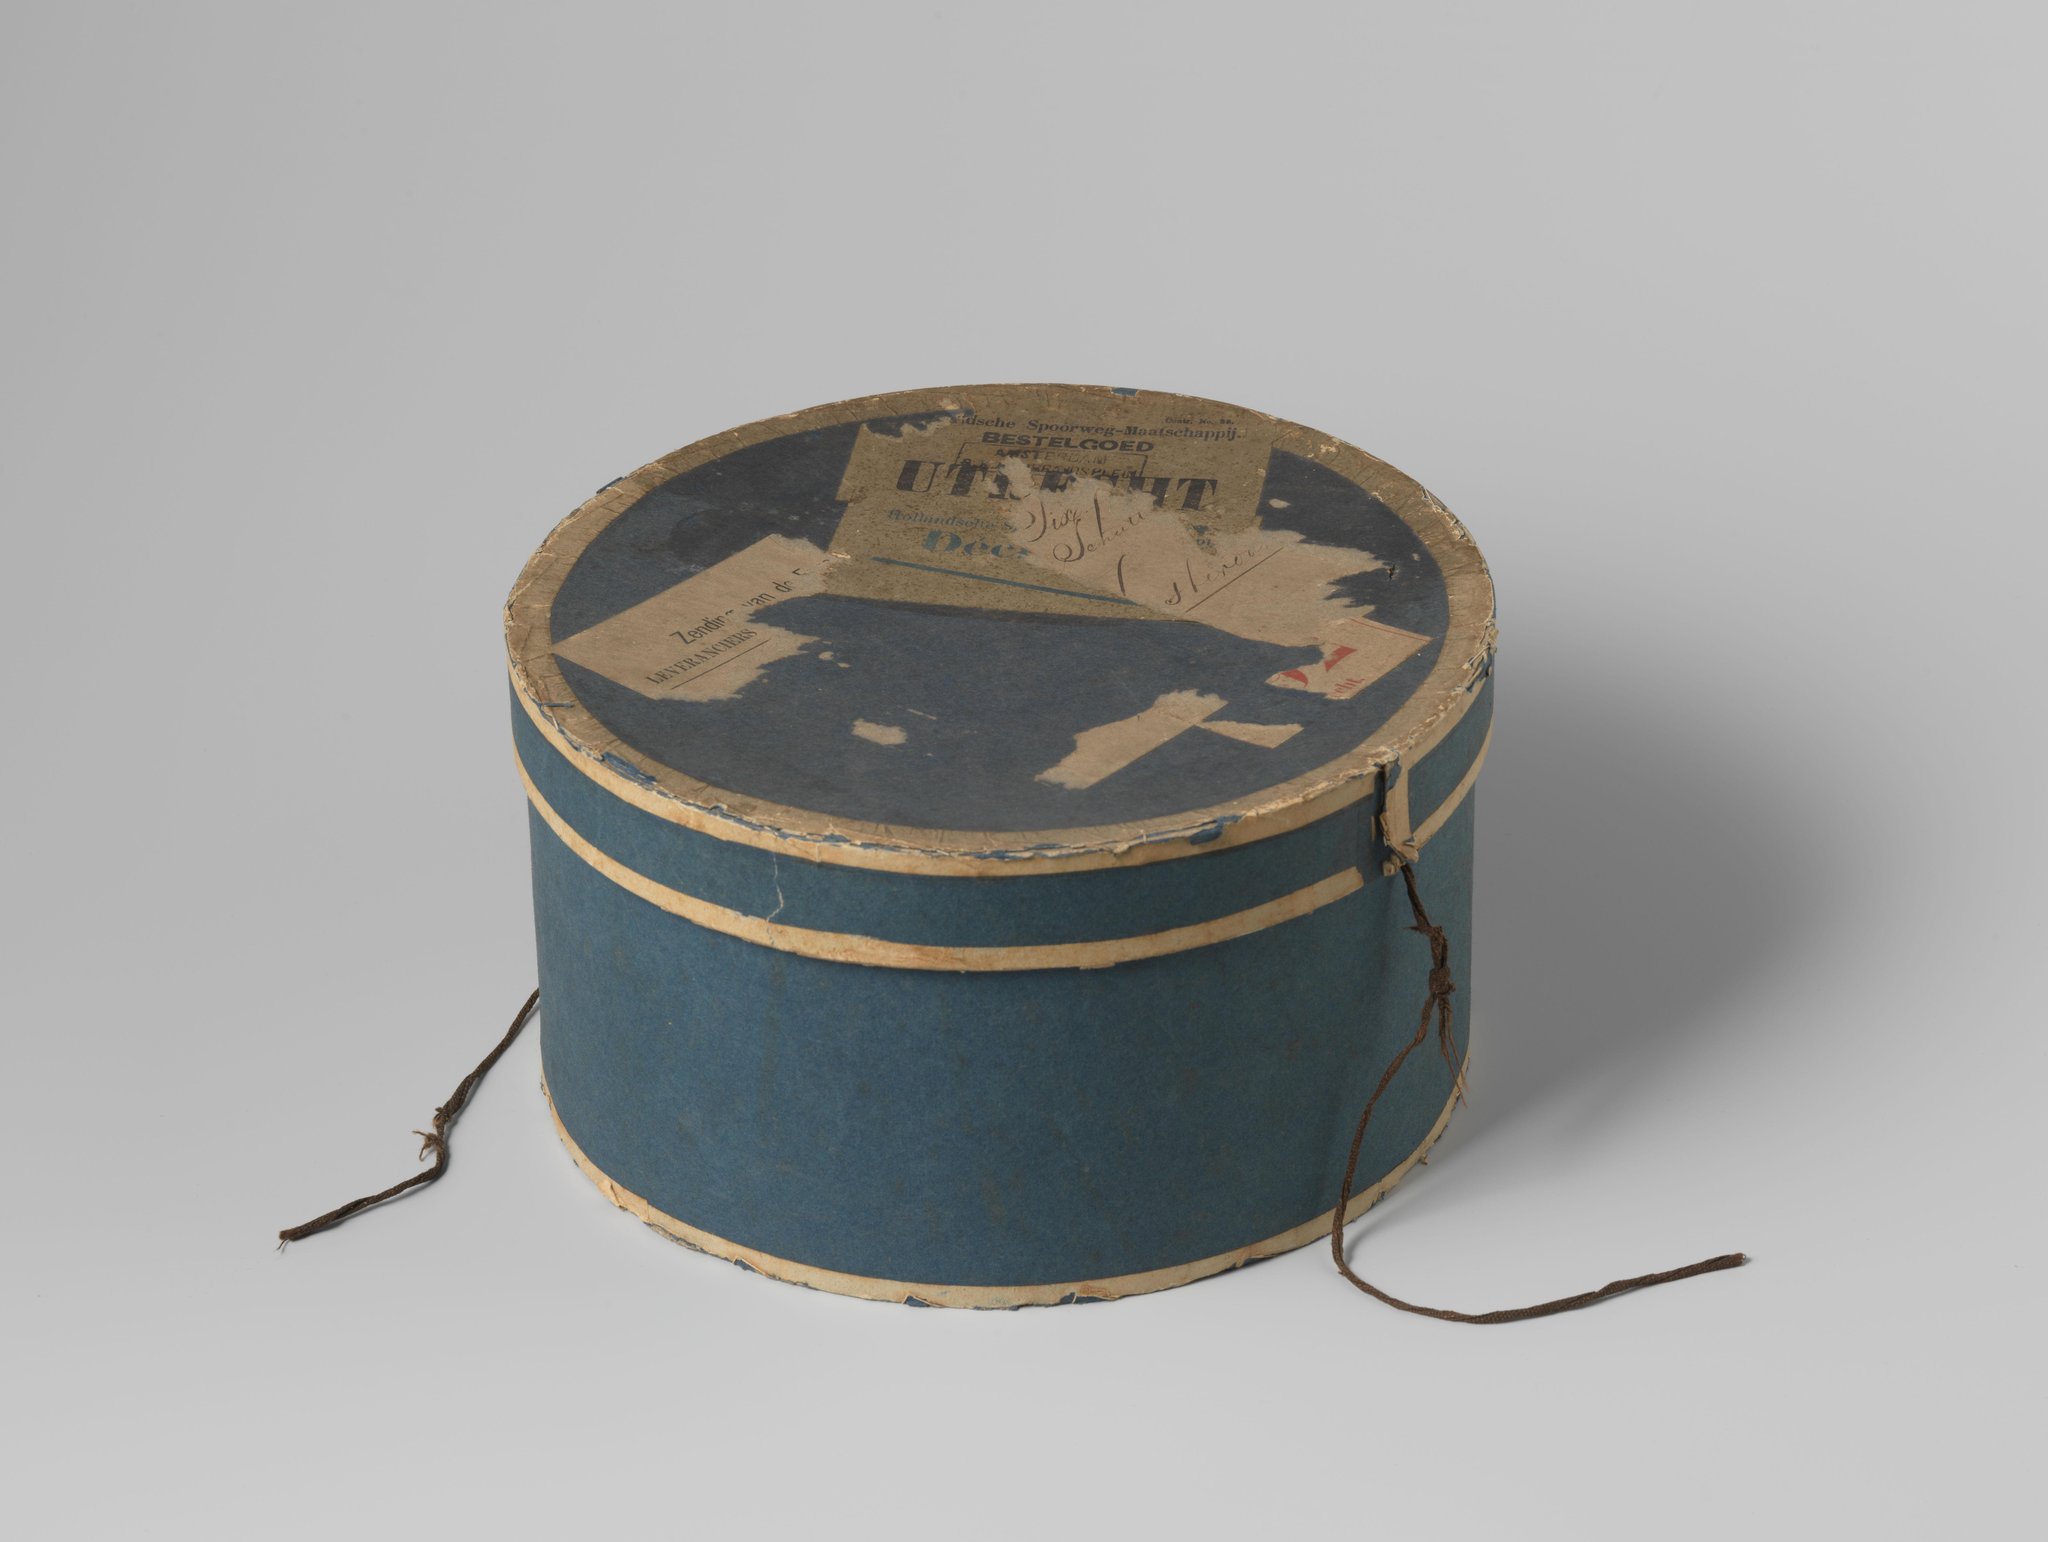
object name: menswear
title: Ronde doos van blauw karton, beplakt met witte lijsten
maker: Anonymous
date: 1890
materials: cardboard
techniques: pasting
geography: utrecht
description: Ronde doos van blauw karton, beplakt met witte lijsten.